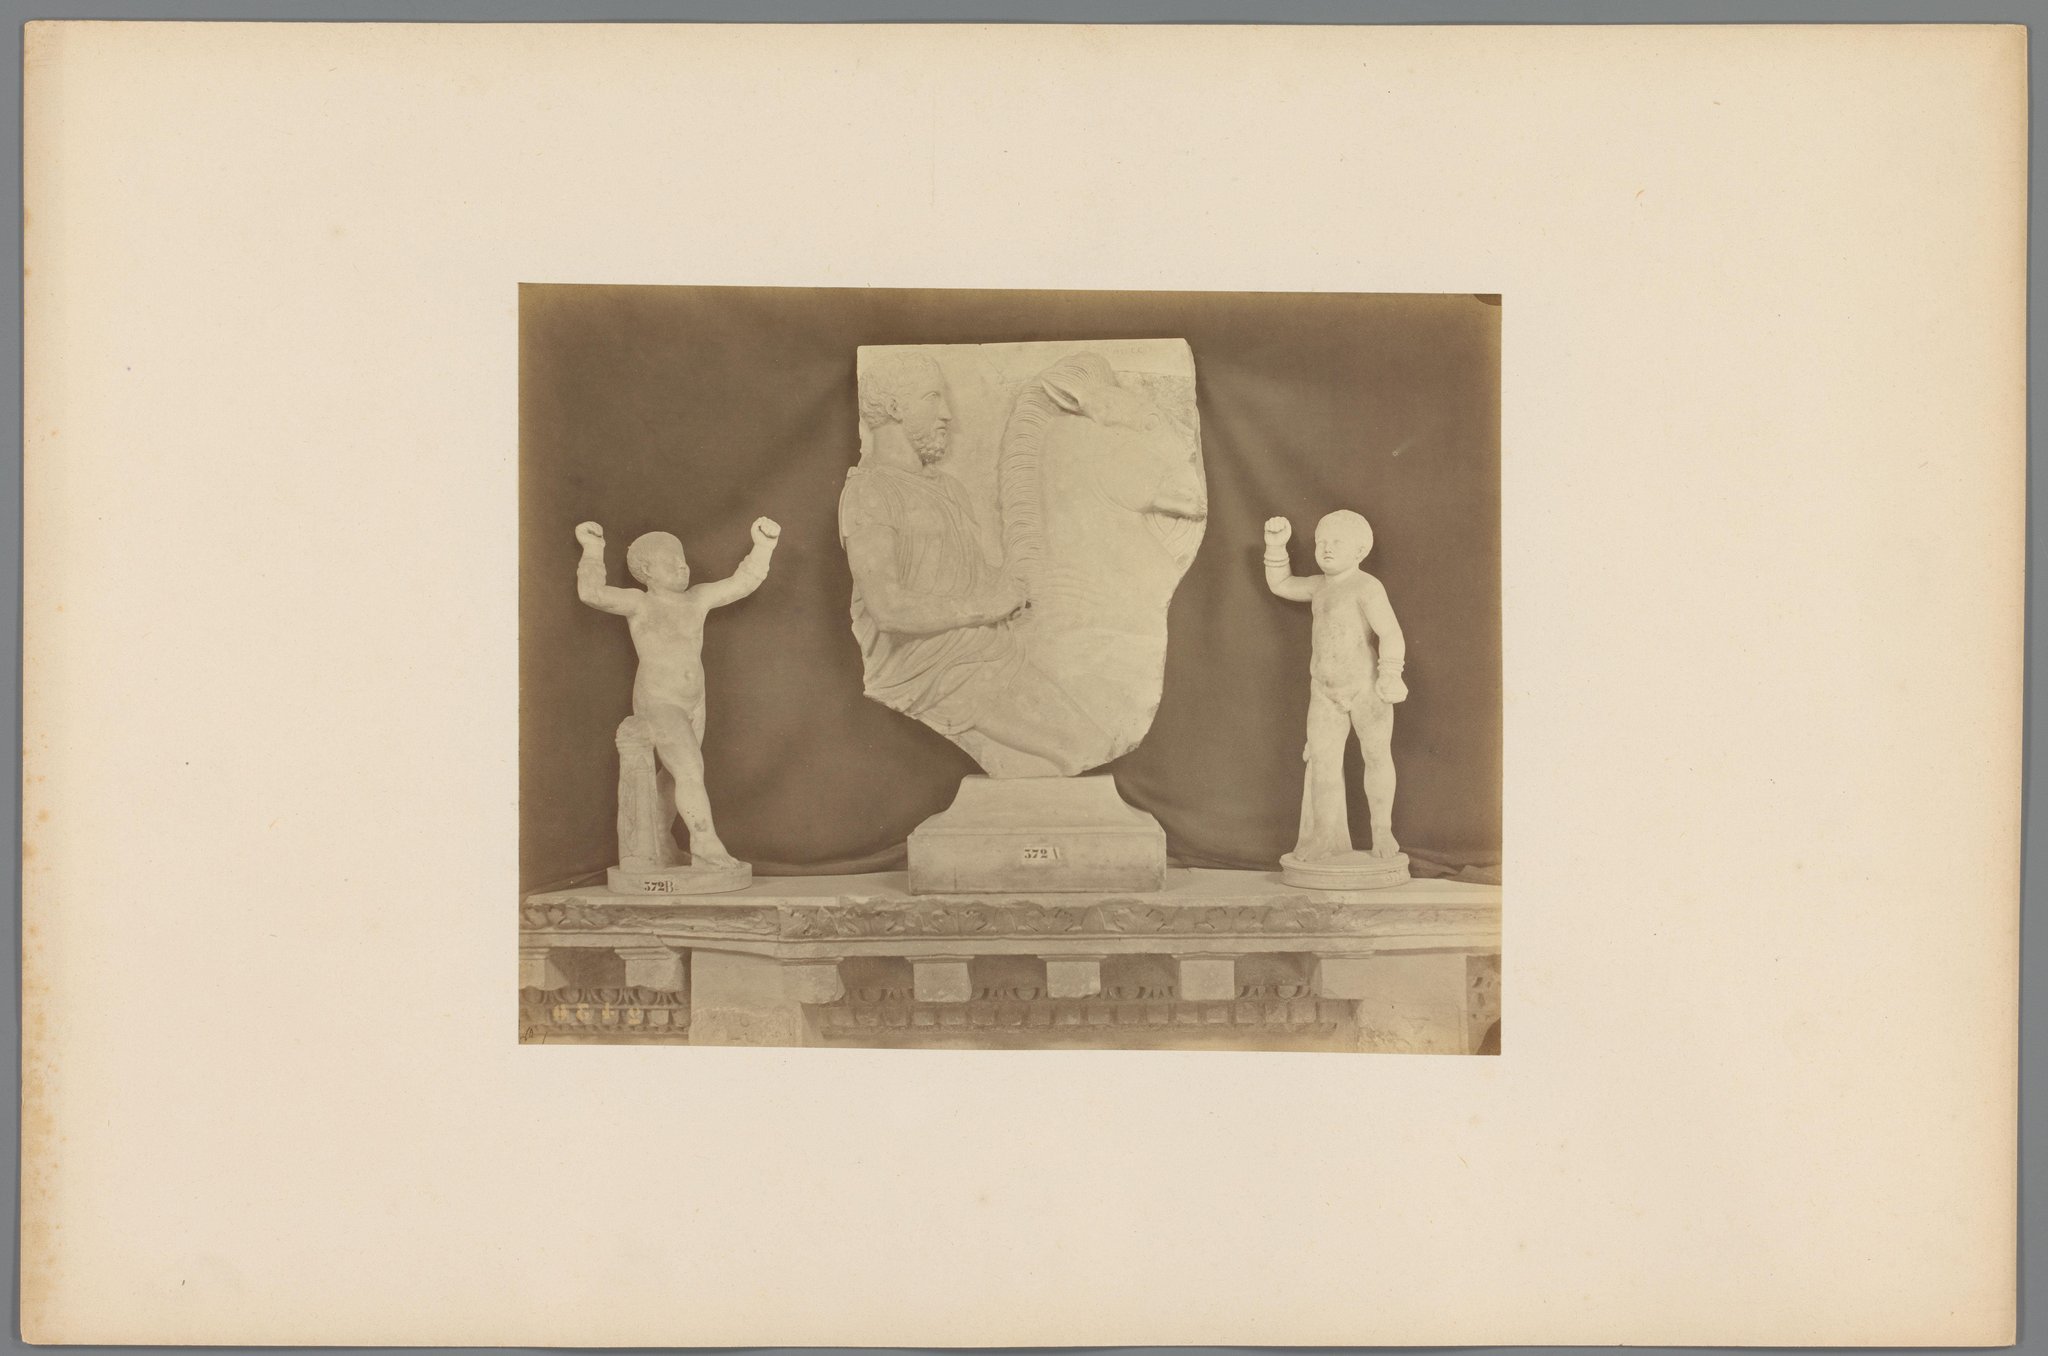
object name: photograph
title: Twee sculpturen van kinderen en een reliëf van een deel van een man te paard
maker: Anonymous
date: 1851-1900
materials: cardboard, paper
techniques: albumen print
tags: piece of sculpture, reproduction of a piece of sculpture, art (+ relief ~ sculpture)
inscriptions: number: ‘3420’